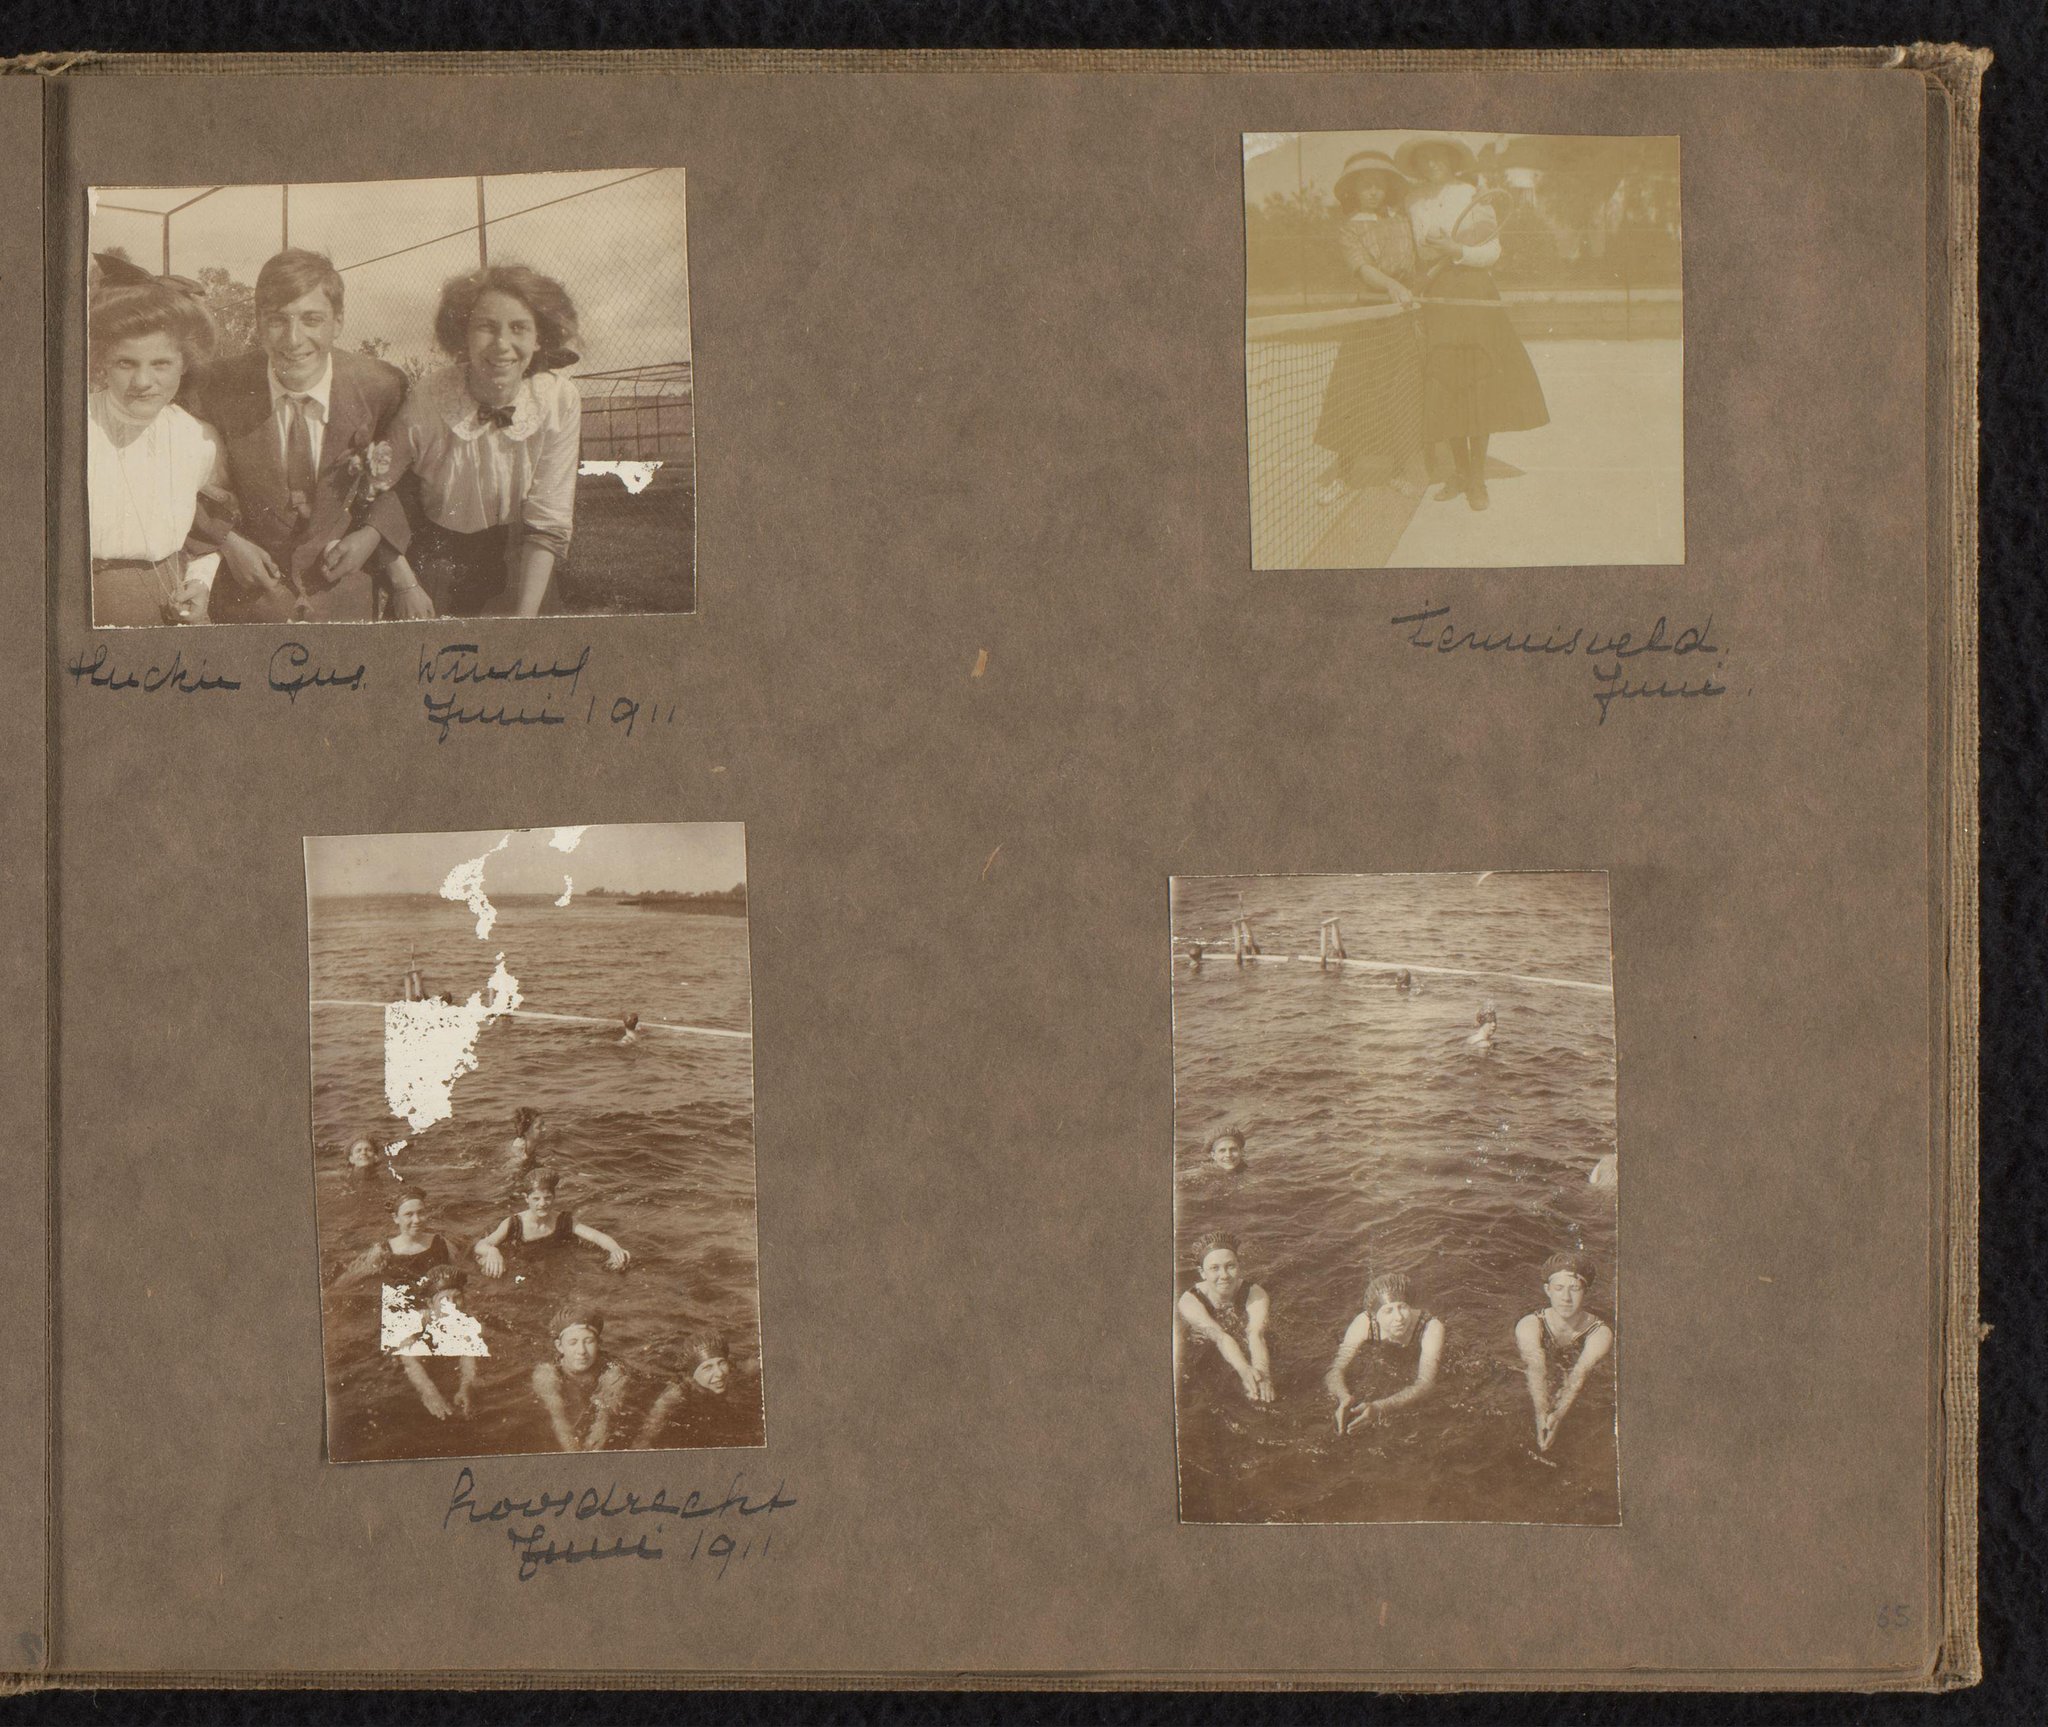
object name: photograph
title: Vier foto's van vrienden van Loentje Onnen op de tennisbaan en zwemmend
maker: carolina frederika onnen (lien/loen)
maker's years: 1896-1983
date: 1906-1911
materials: paper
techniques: gelatin silver print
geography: netherlands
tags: tennis, lawn-tennis, swimming (movement in water), friends, historical persons not known by name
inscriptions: inscription: ‘Huckie Gus Winny/ Juni 1911’, inscription: ‘Tennisveld/ Juni’, inscription: ‘Loosdrecht/ Juni 1911’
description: Deze foto's maken deel uit van een album.